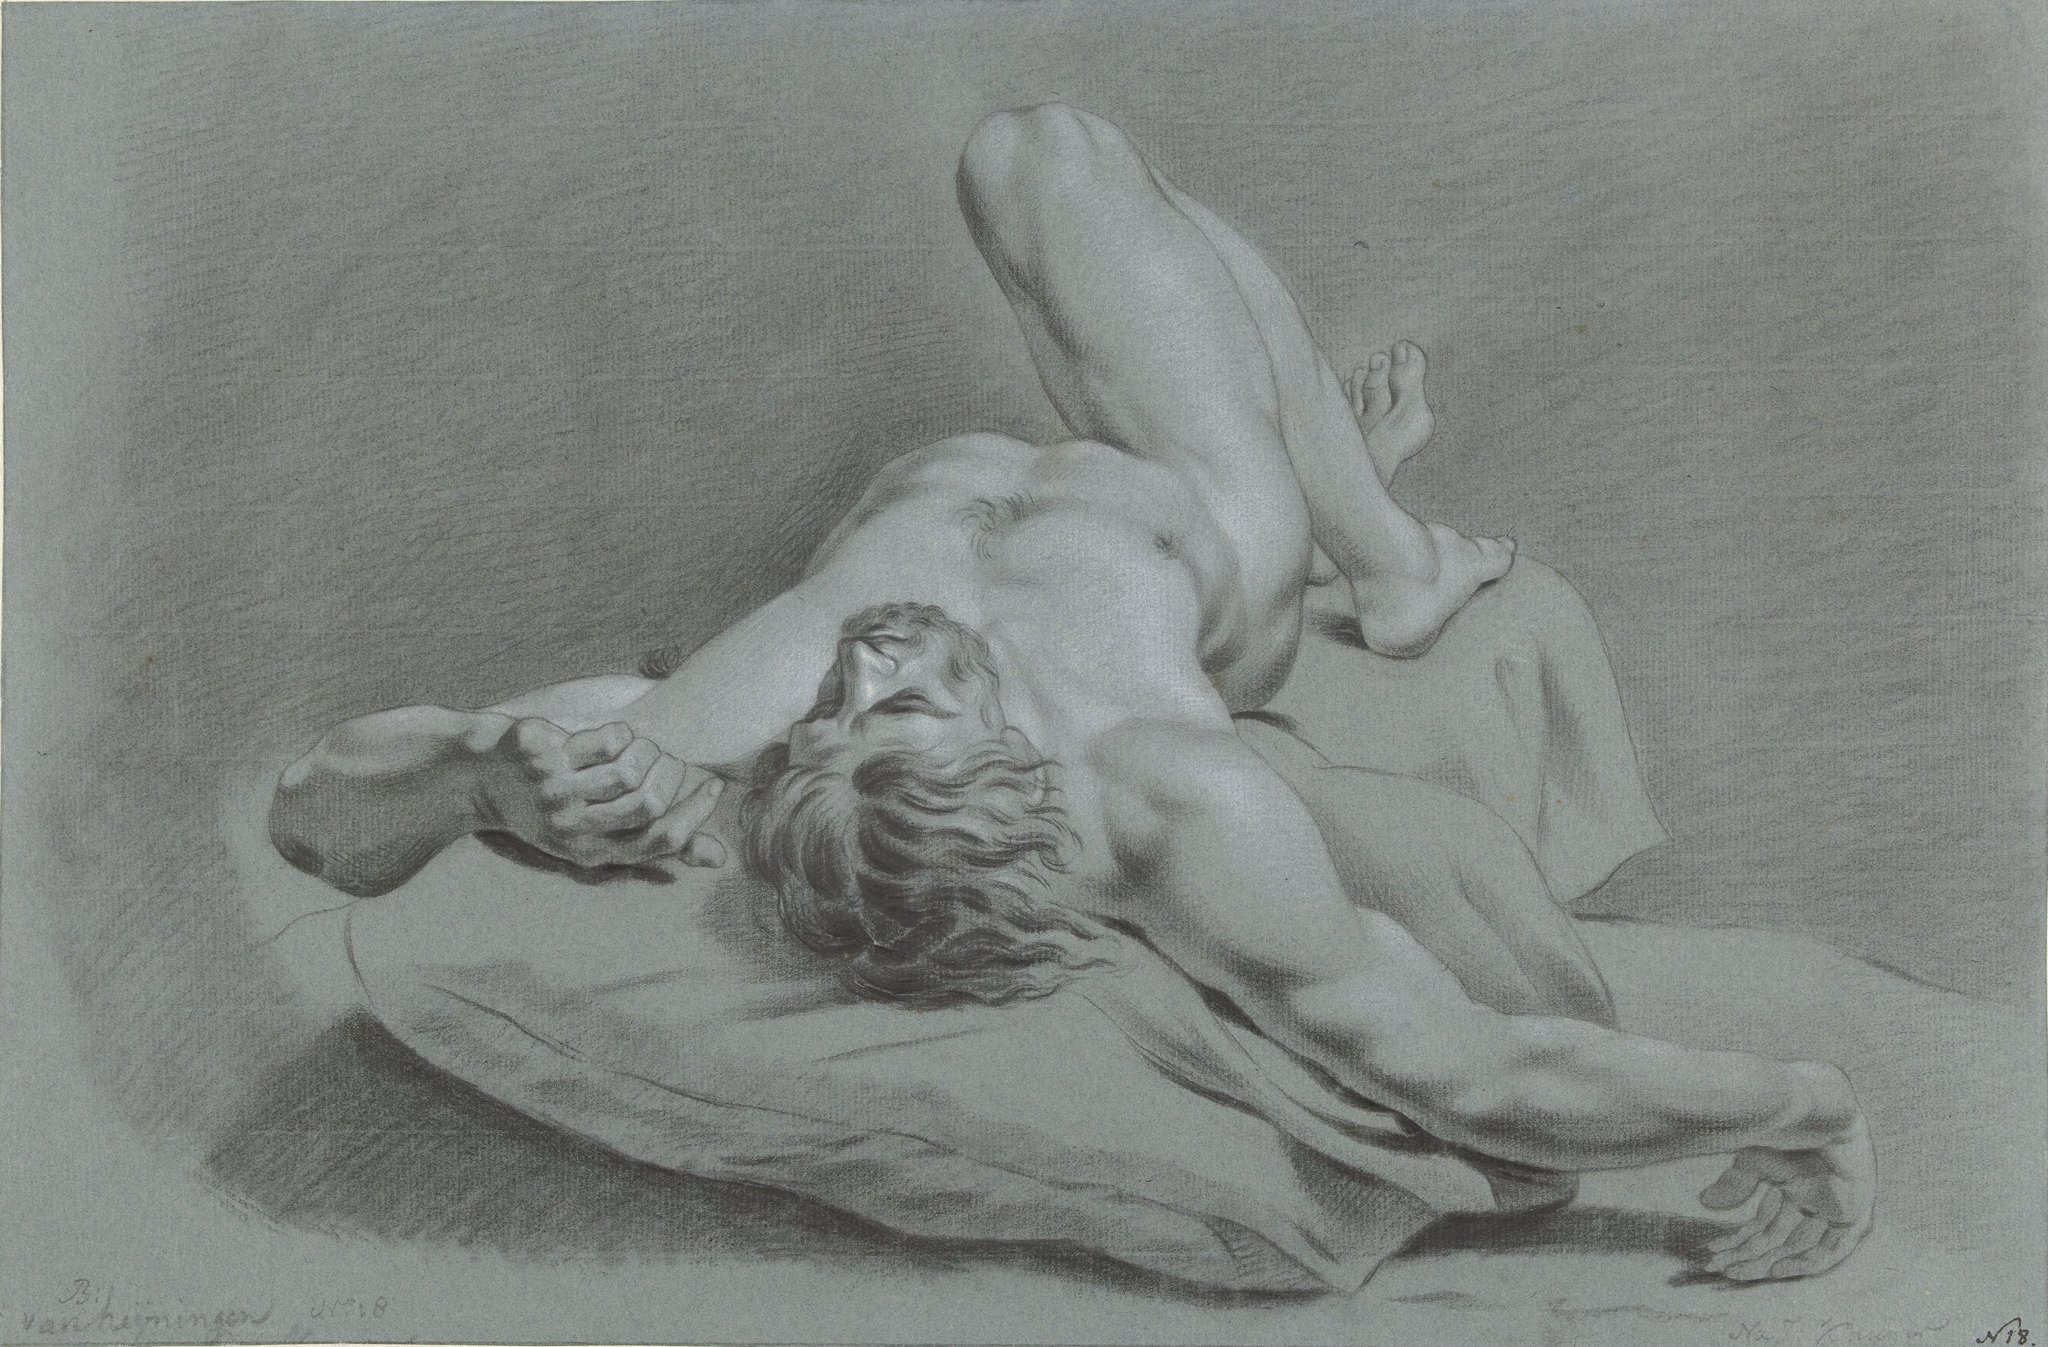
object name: drawing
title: Liggend mannelijk naakt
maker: b. van heijningen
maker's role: draughtsman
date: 1771-1858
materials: chalk, paper